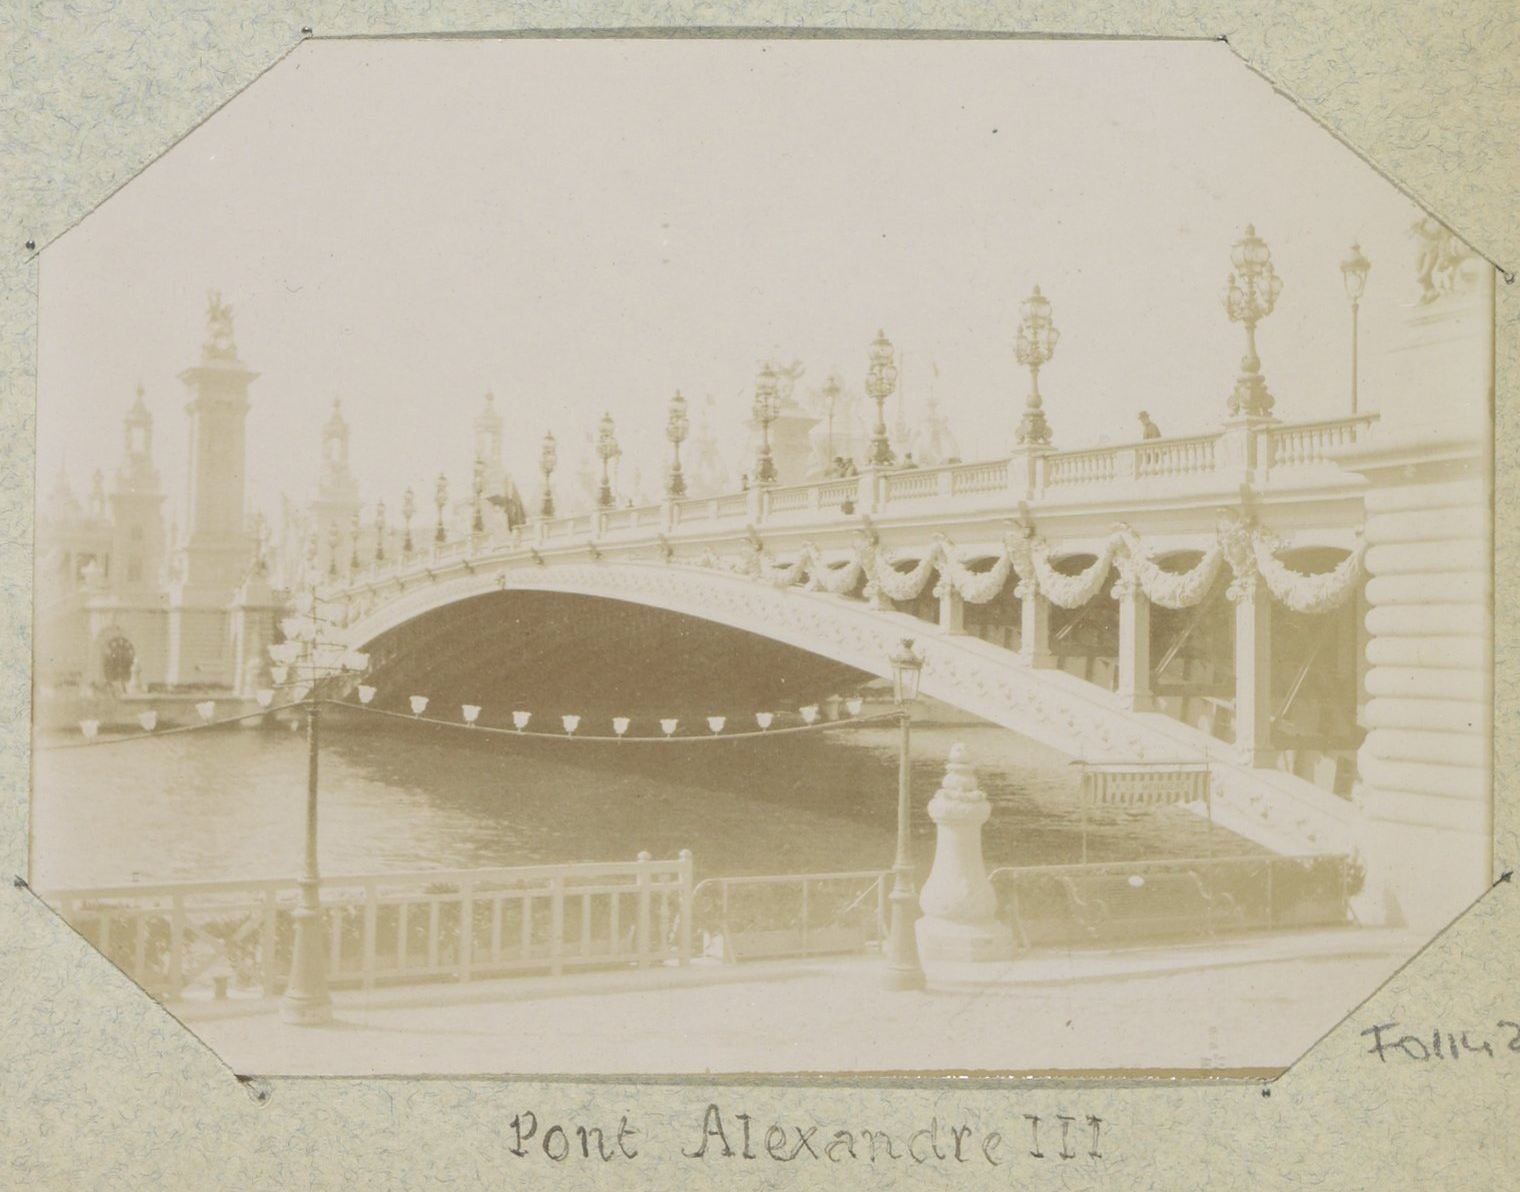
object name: photograph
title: Gezicht op de Pont Alexandre-III tijdens de Wereldtentoonstelling van 1900 in Parijs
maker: paul lucena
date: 1900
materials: paper, photographic support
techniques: daylight paper print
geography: paris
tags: world fair, world exhibition, bridge, paris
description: Onderdeel van Album van een Franse amateur met foto's van Frankrijk, Algerije, Palmyra, de Wereldtentoonstelling van 1900 en van bekende Fransen.